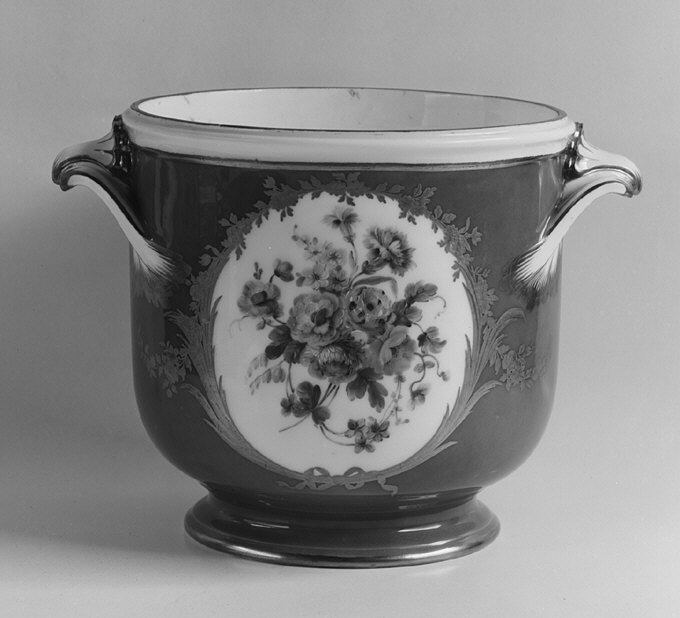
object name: half bottle cooler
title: Half-bottle cooler (seau à demi-bouteille) (one of two) (part of a service)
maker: sèvres manufactory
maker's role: manufactory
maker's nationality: french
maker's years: 1740-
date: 1771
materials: soft paste porcelain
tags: flowers